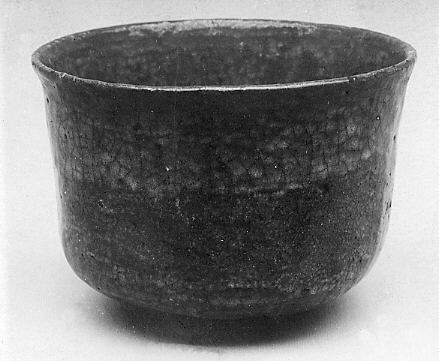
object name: teabowl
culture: japanese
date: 1801-1900